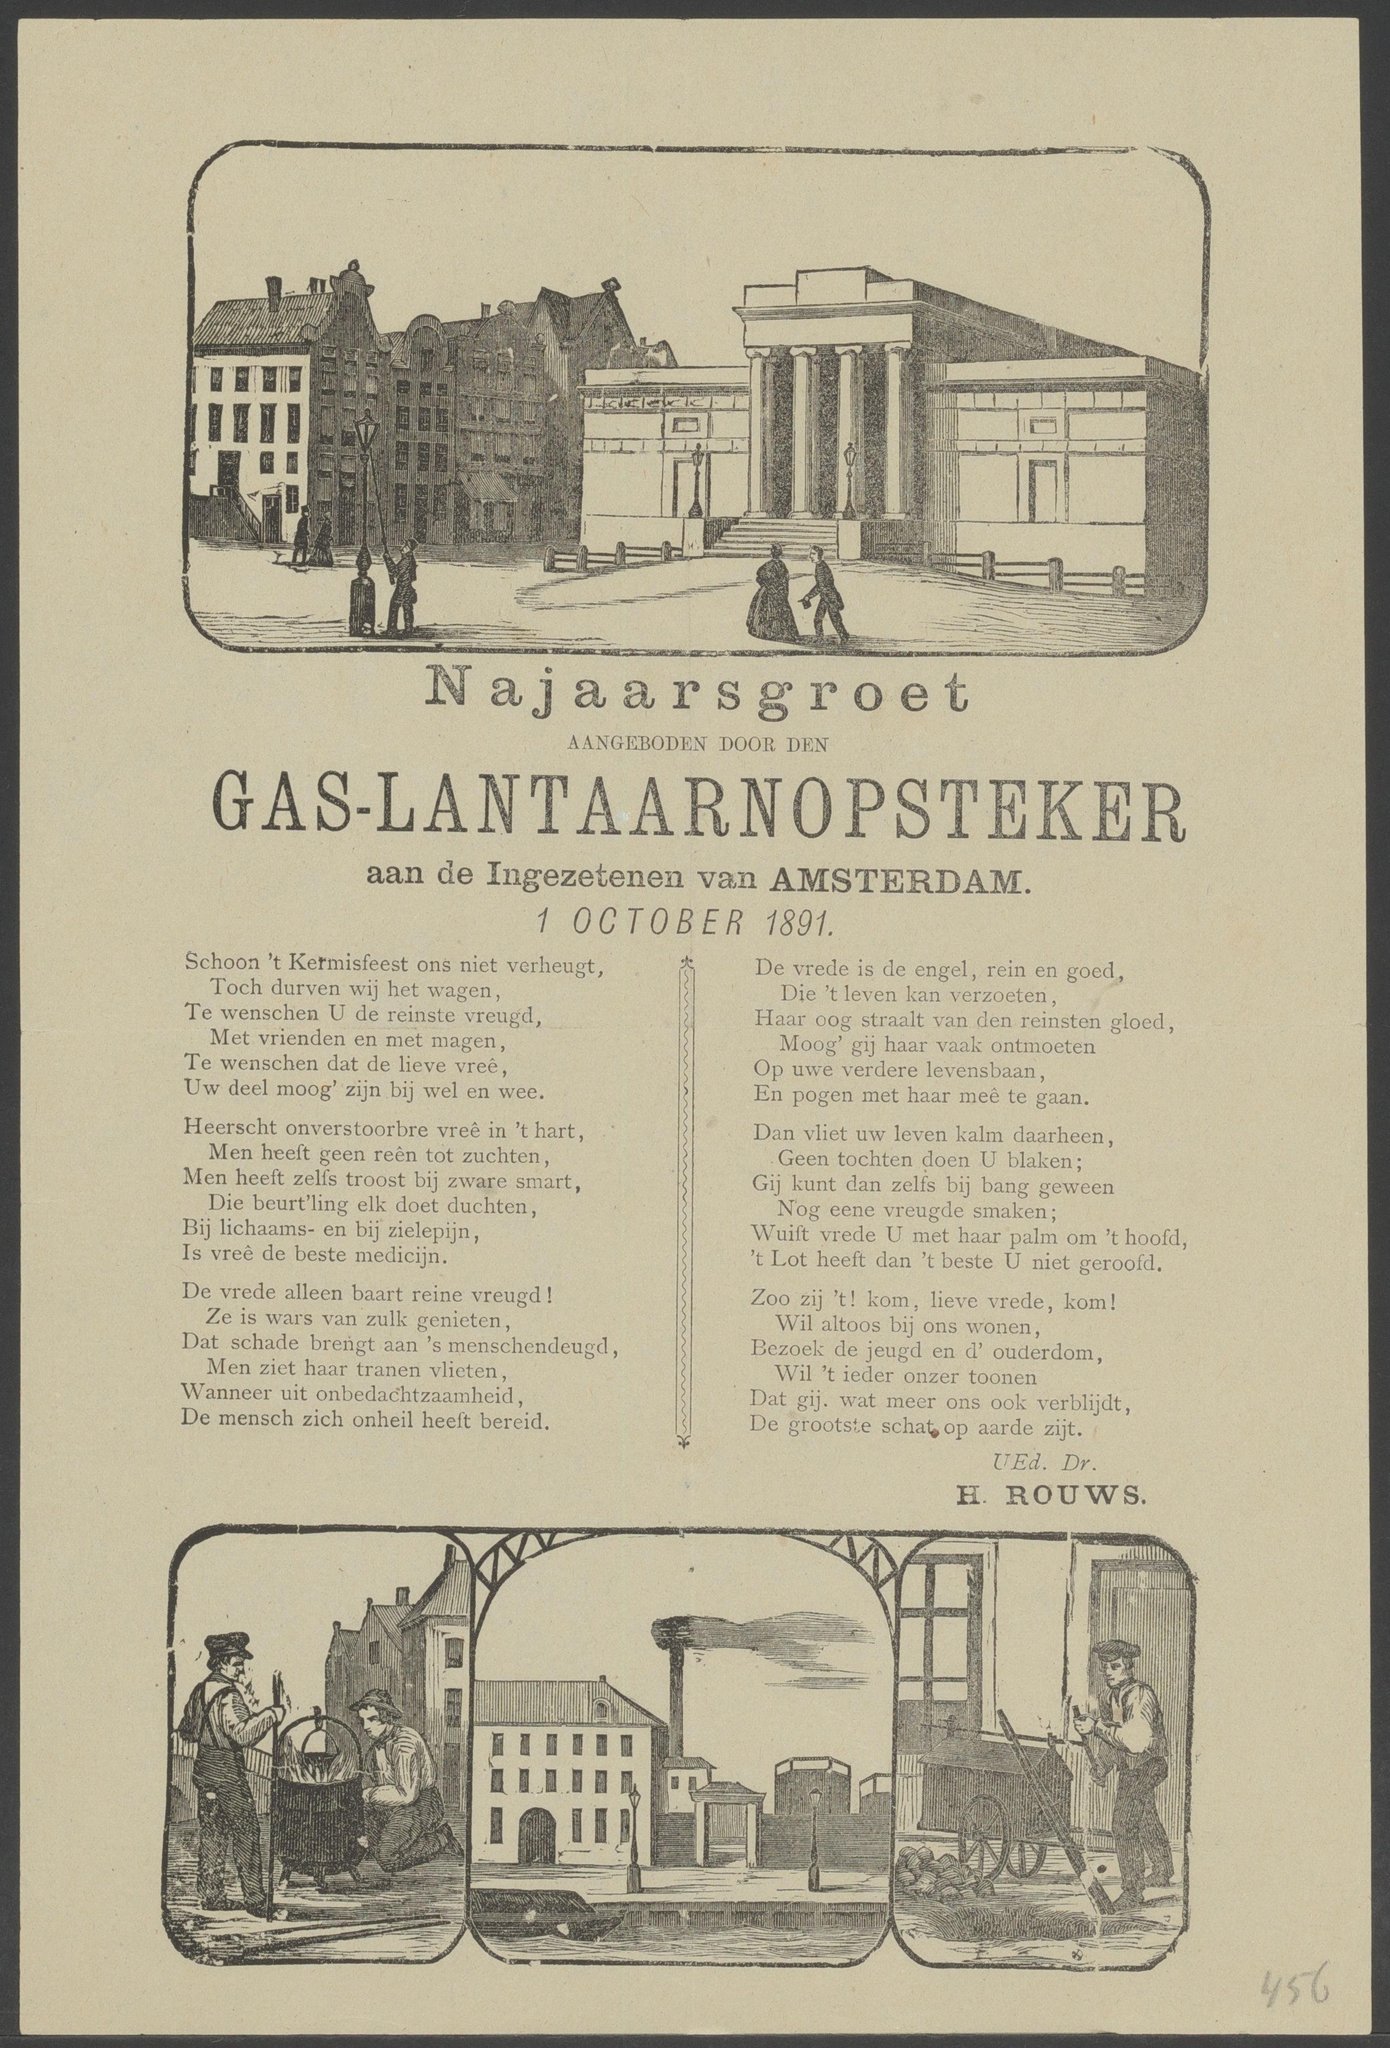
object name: print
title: Kermiswens van de gaslantaarnopstekers van Amsterdam voor het jaar 1891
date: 1891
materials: paper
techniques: letterpress printing, engraving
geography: amsterdam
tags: gas-lamp, gas supply, digging (industrial process), street lighting, amsterdam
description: Kermiswens van de Amsterdamse gaslantaarnopstekers voor het jaar 1891. Centraal een vers in twee kolommen. Bovenaan de Dam met de beurs van Zocher te Amsterdam. Onderaan de Hollandsche Gasfabriek en twee gasfitters aan het werk. Van de gaslantaarnopsteker: H. Rouws. Onderwerpsrubrieken binnen de Atlas Zeden en Gewoonten: Zeden en gewoonten in engeren zin, Volksleven, Volksbladen, Nieuwjaars- en Kerstwenschen, Amsterdam.